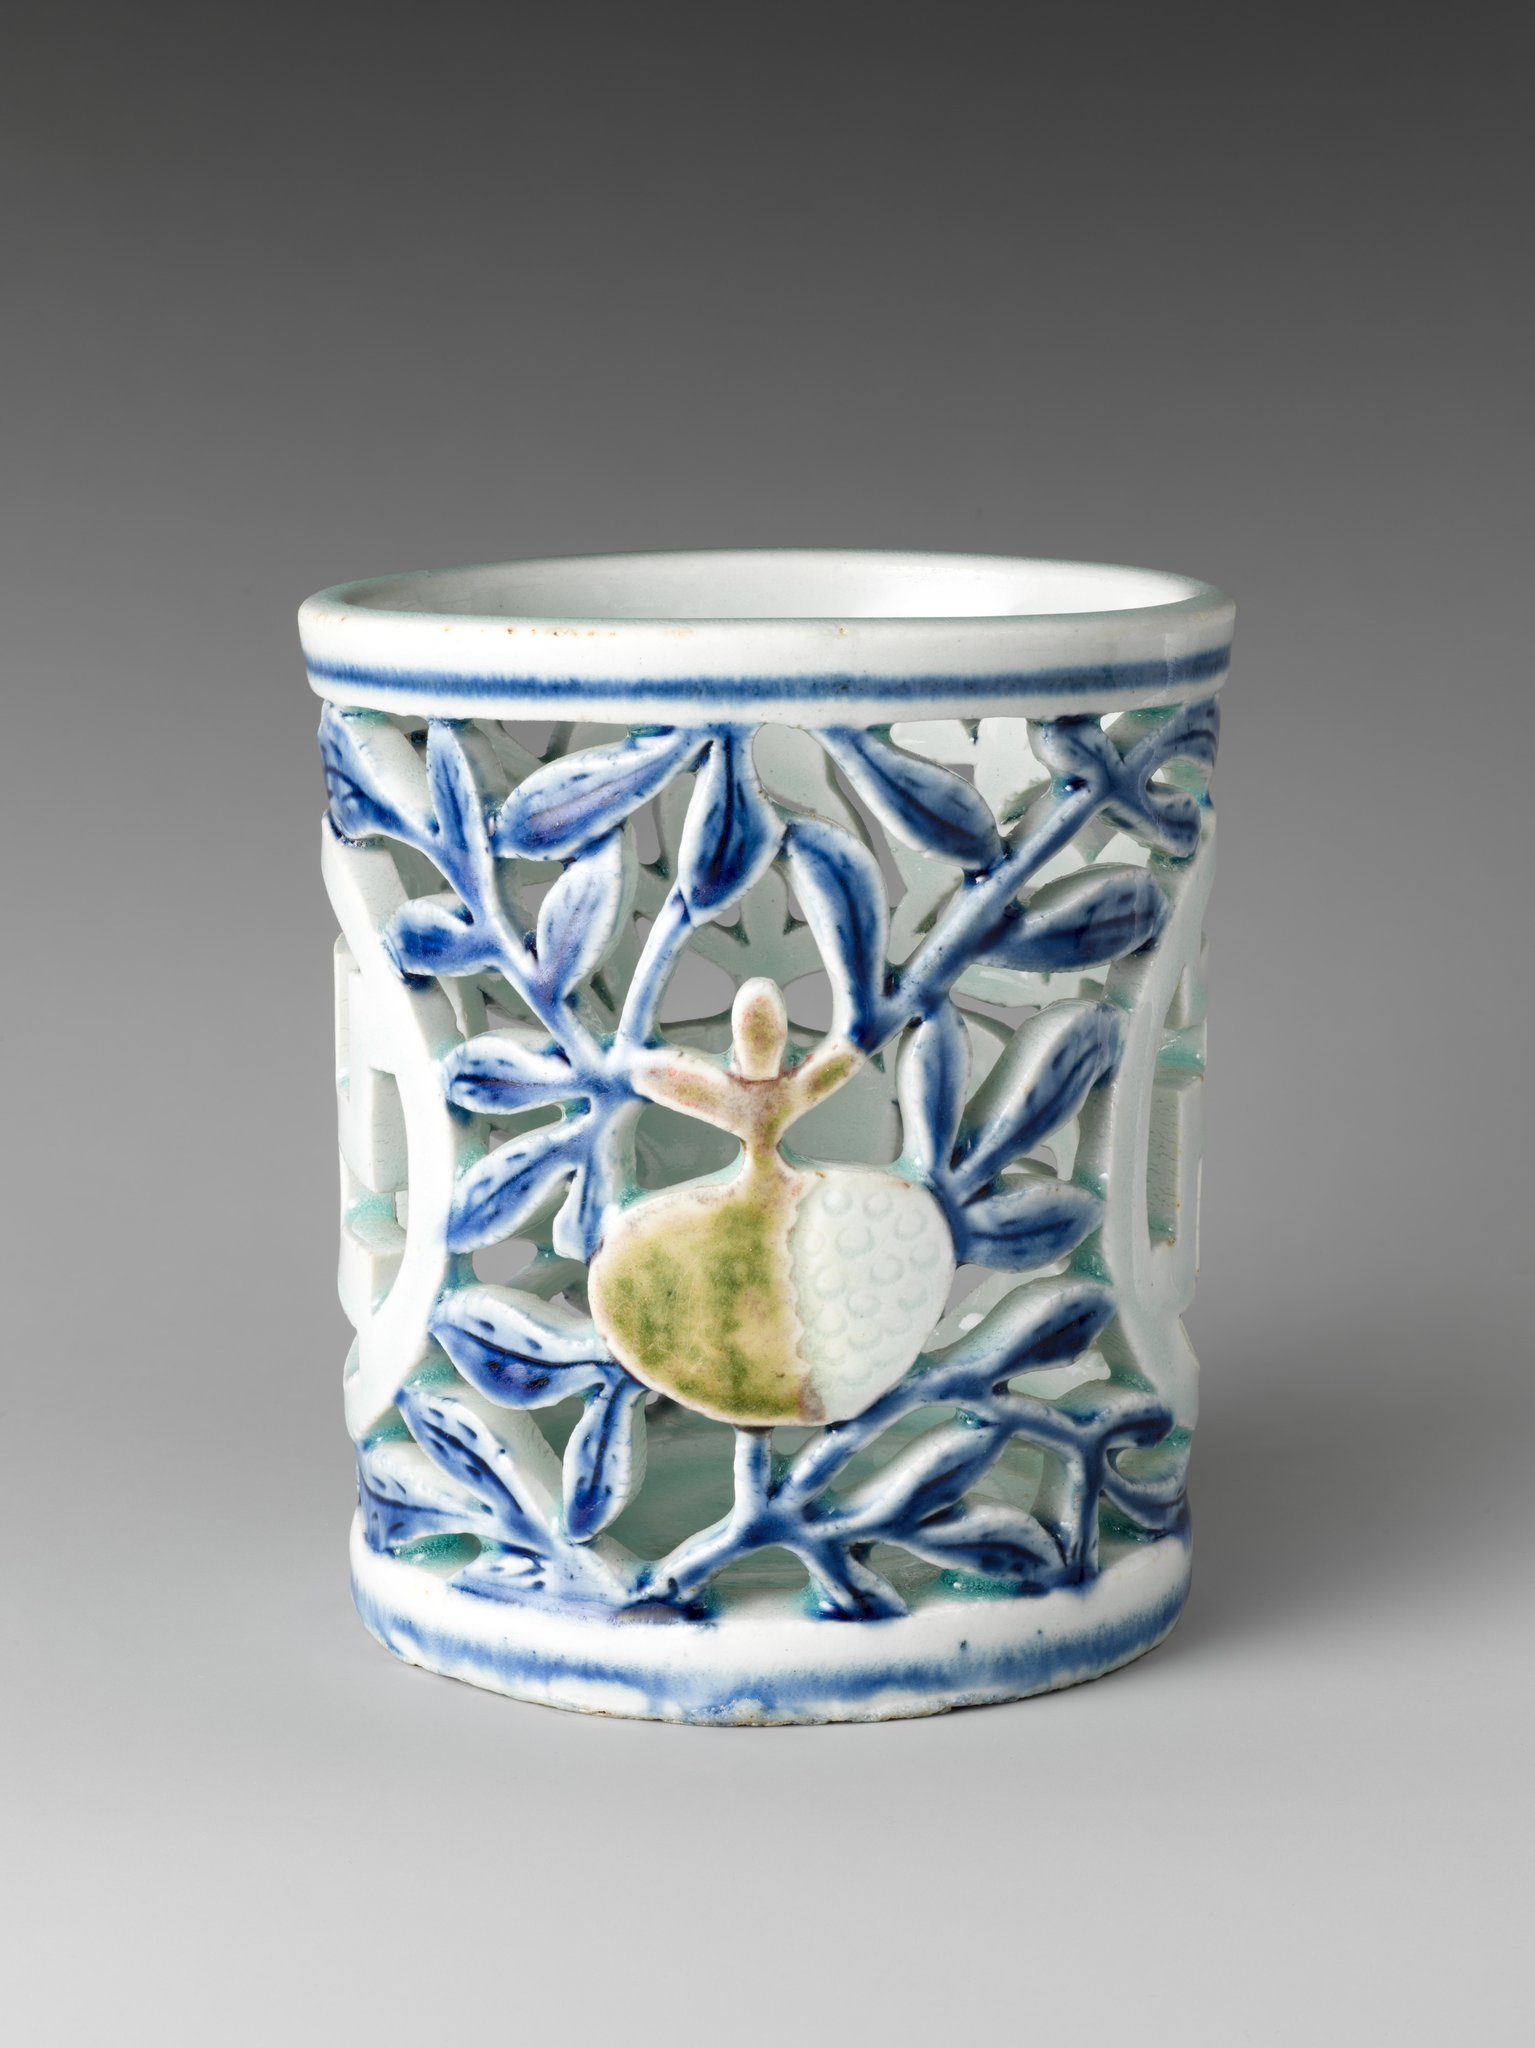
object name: brush pot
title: Brush holder with pomegranate and inscription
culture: korean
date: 1801-1900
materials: cobalt, copper, porcelain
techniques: underglaze